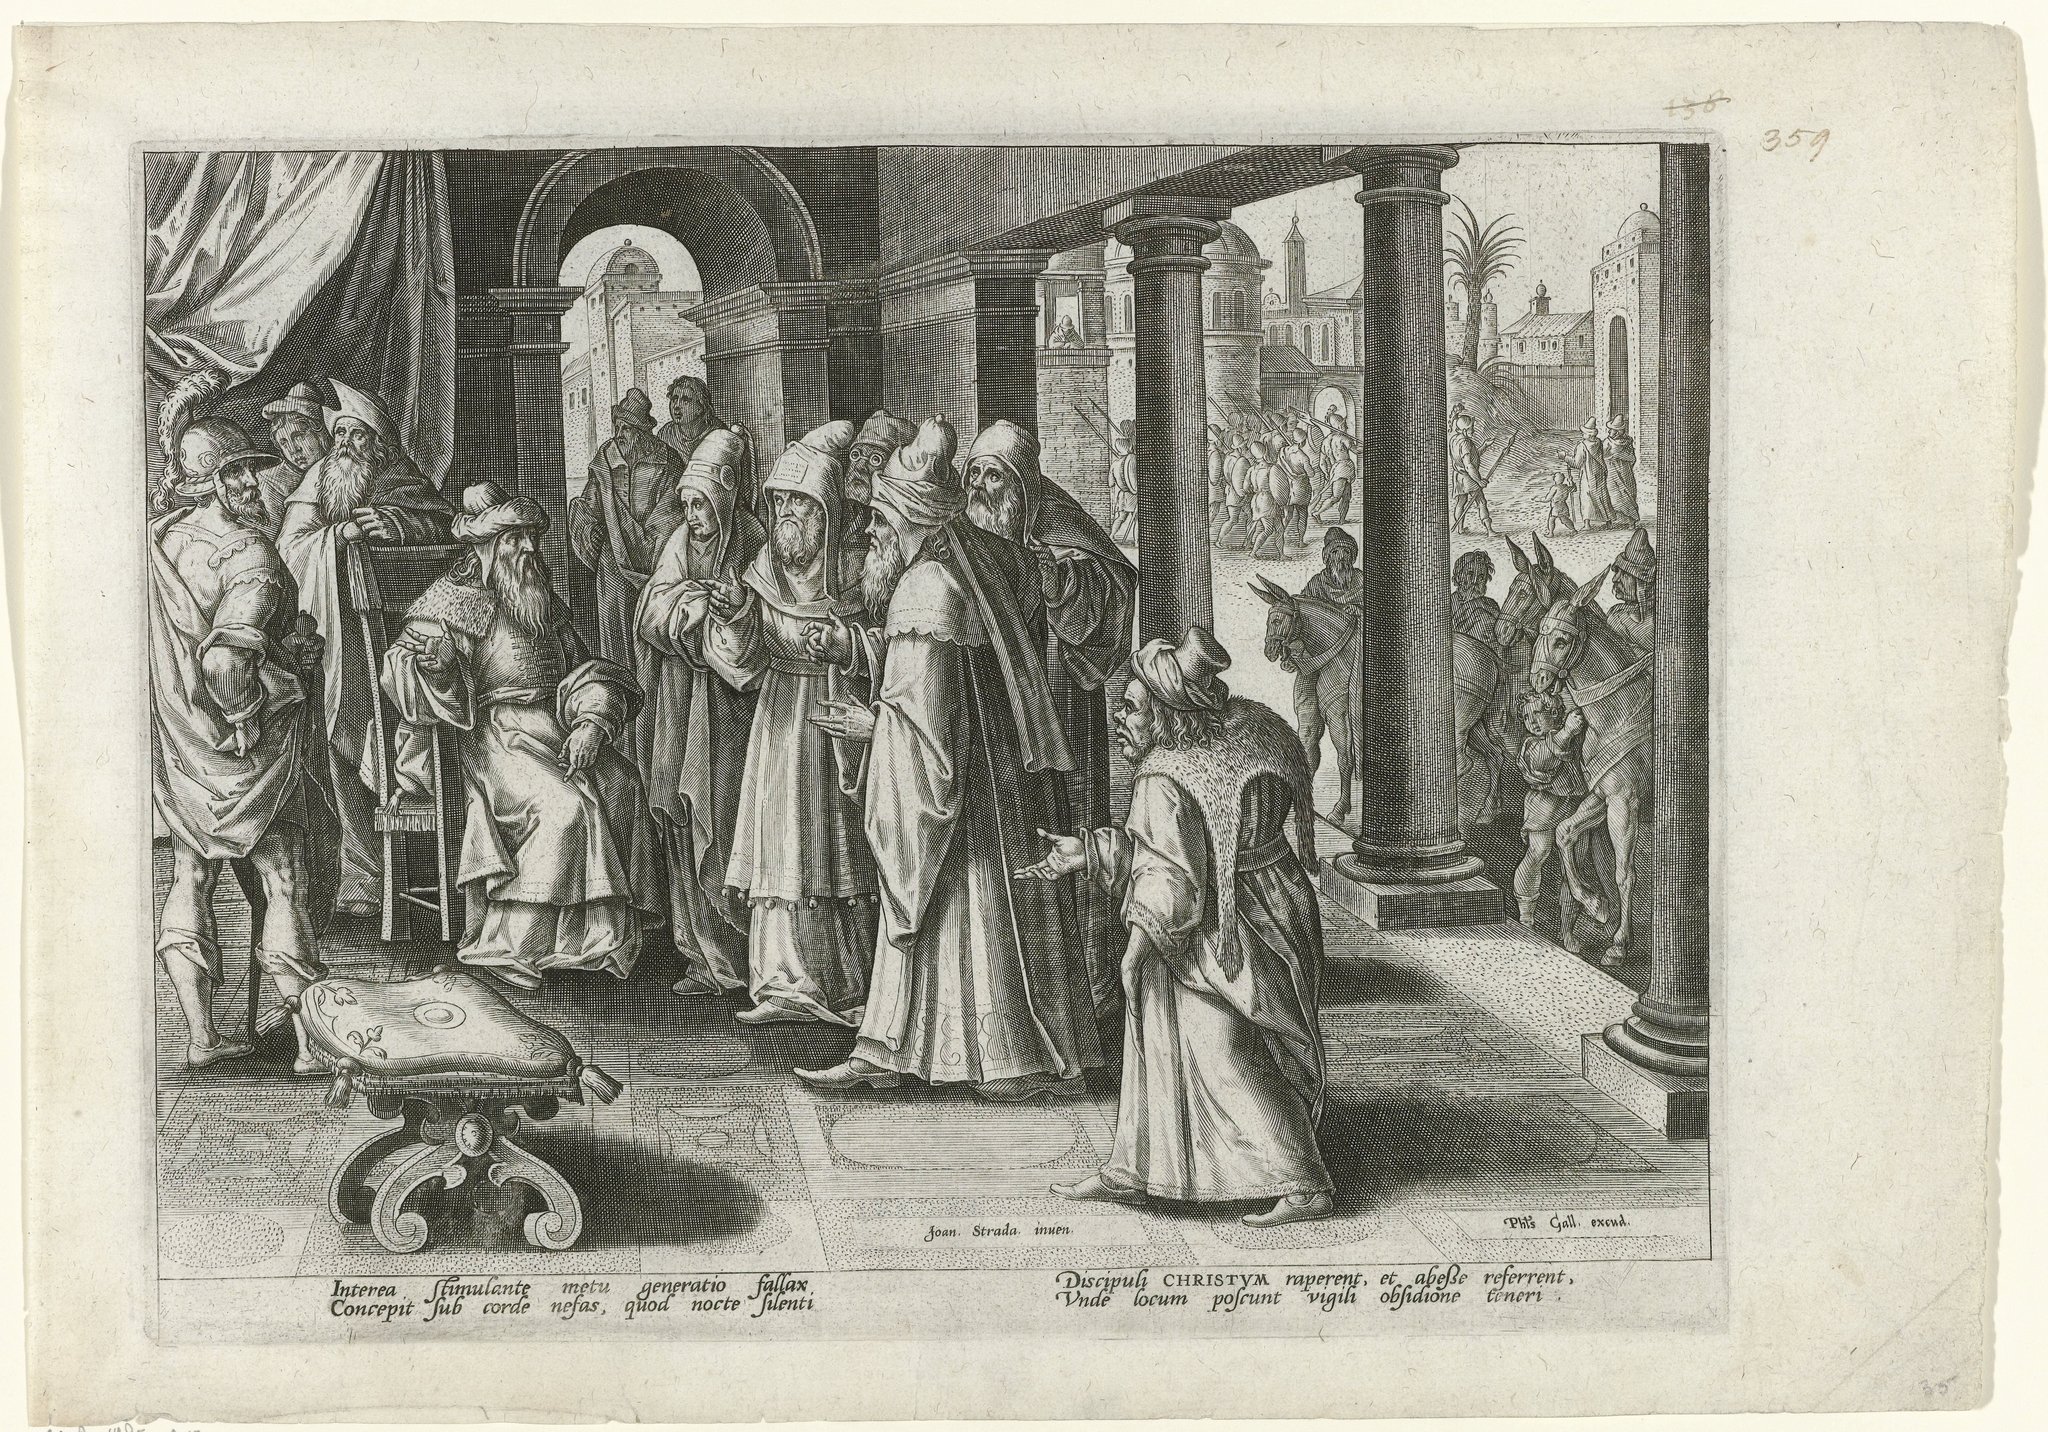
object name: print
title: Passie, dood en wederopstanding van Christus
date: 1585-1586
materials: paper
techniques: engraving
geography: antwerp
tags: the jews ask pilate to have the sepulchre guarded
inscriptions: number: ‘359’, collector's mark: Lugt 2228, collector's mark: Lugt 2760, watermark:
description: De Farizeeën vragen Pilatus het graf van Christus te laten bewaken, zodat zijn volgelingen het lijk niet stelen. In de achtergrond vertrekt een groep soldaten naar het graf. De prent heeft een Latijns onderschrift en maakt deel uit van een serie over de passie, dood en wederopstanding van Christus.